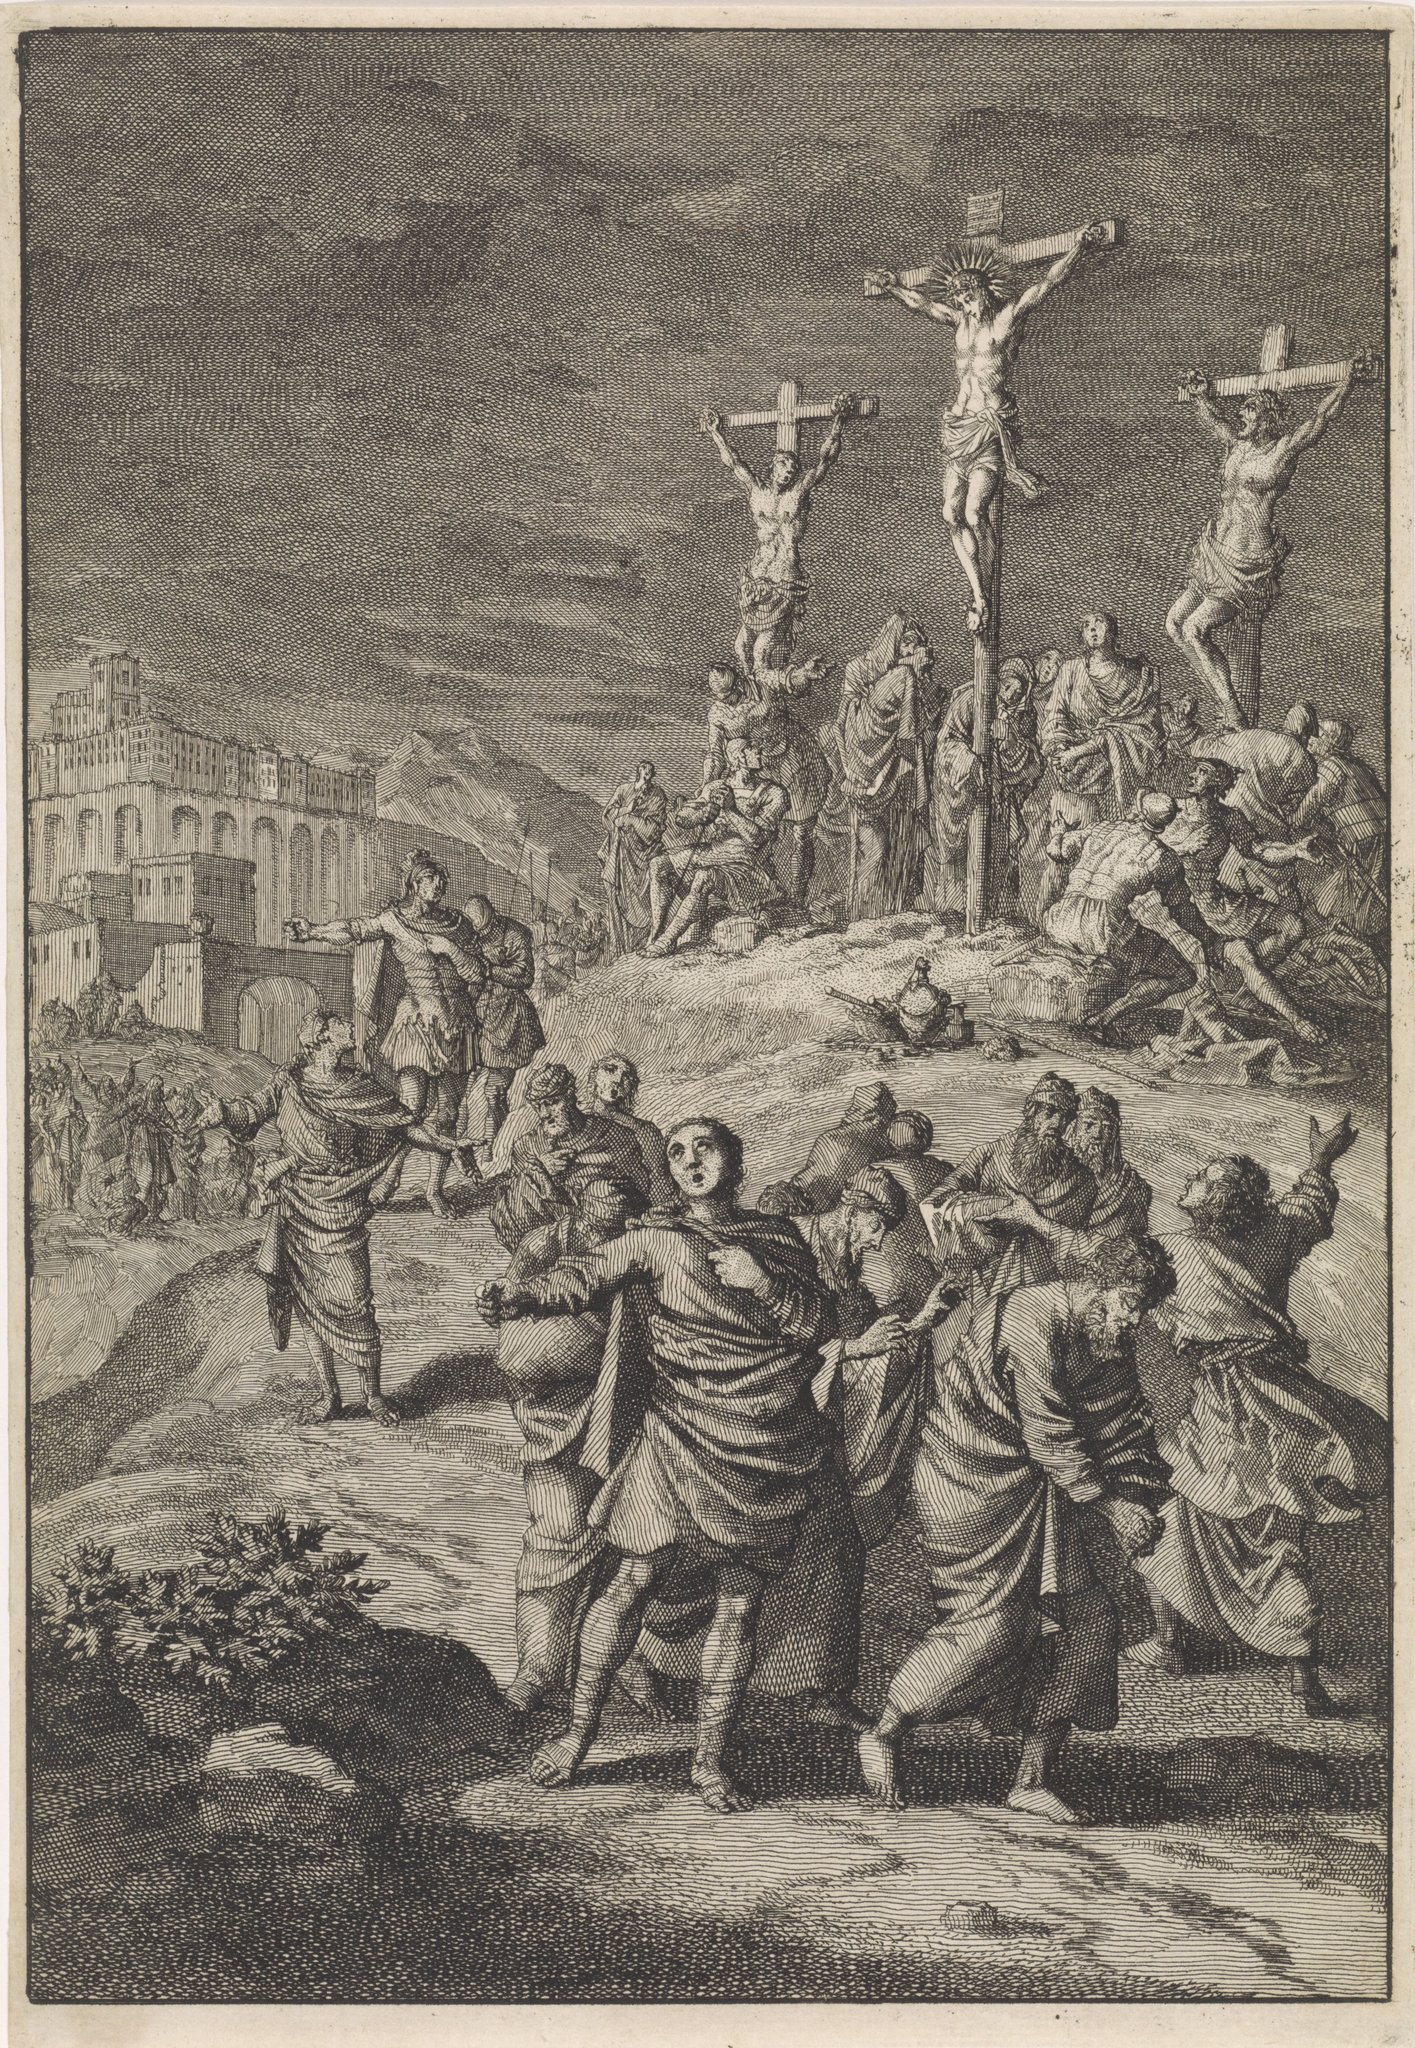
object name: print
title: Zonsverduistering bij de dood van Christus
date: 1700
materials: paper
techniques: etching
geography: amsterdam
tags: darkness from the sixth to the ninth hour (represented by a solar eclipse) ~ christ's death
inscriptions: collector's mark: Lugt 2228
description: De berg Golgota met Christus aan het kruis tussen de twee misdadigers. De zon is verdwenen en het is donker. Mensen slaan zich op de borst in paniek. Op de achtergrond links Jeruzalem.